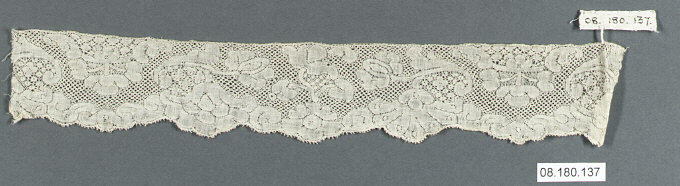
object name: piece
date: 1701-1733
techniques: lace